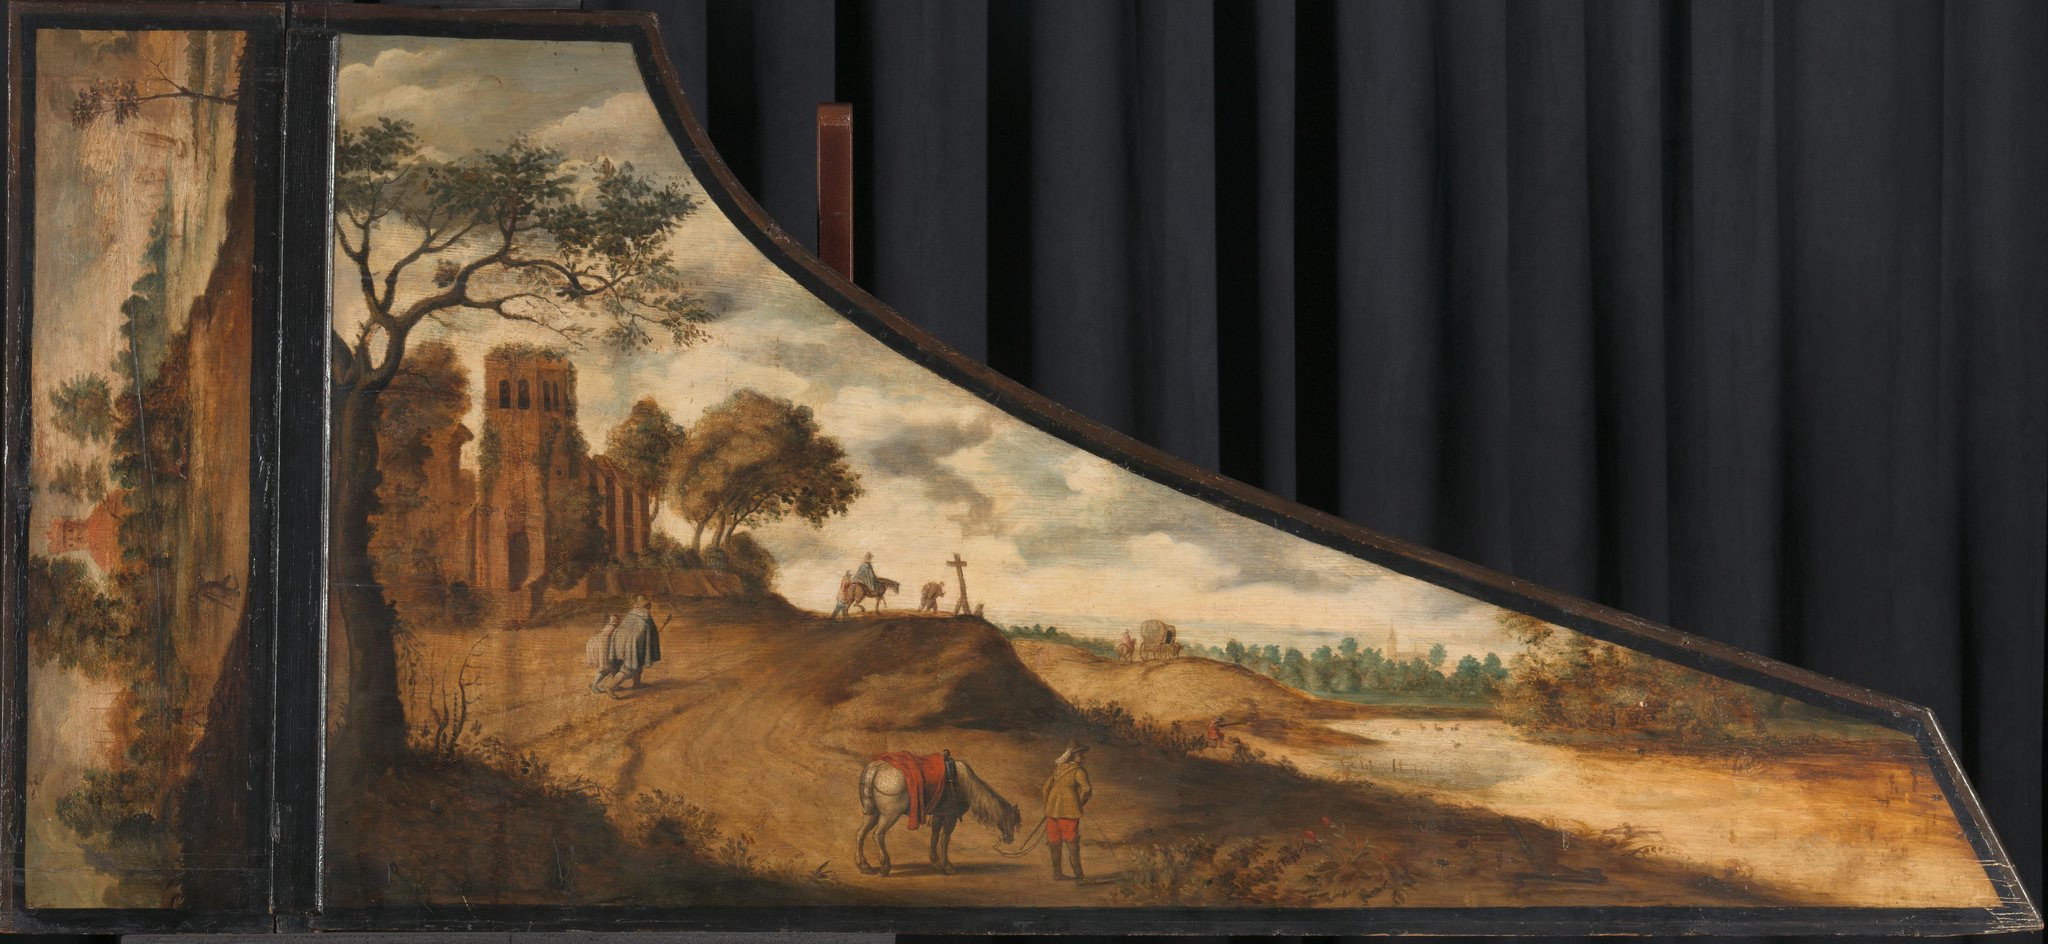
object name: harpsichord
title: Lid of a harpsichord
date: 1625-1650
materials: oil, panel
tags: landscapes in the temperate zone, road, path, urination, 'en route', traveller under way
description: Twee voorstellingen: op de deksel van een clavecimbel is een groot heuvelachtig landschap met reizigers geschilderd. Op de voorgrond een pissende man met zijn paard, links van de weg een oude begroeide kerk. Op het kleinere deel van de clavecimbeldeksel staat een klein rivierlandschap.